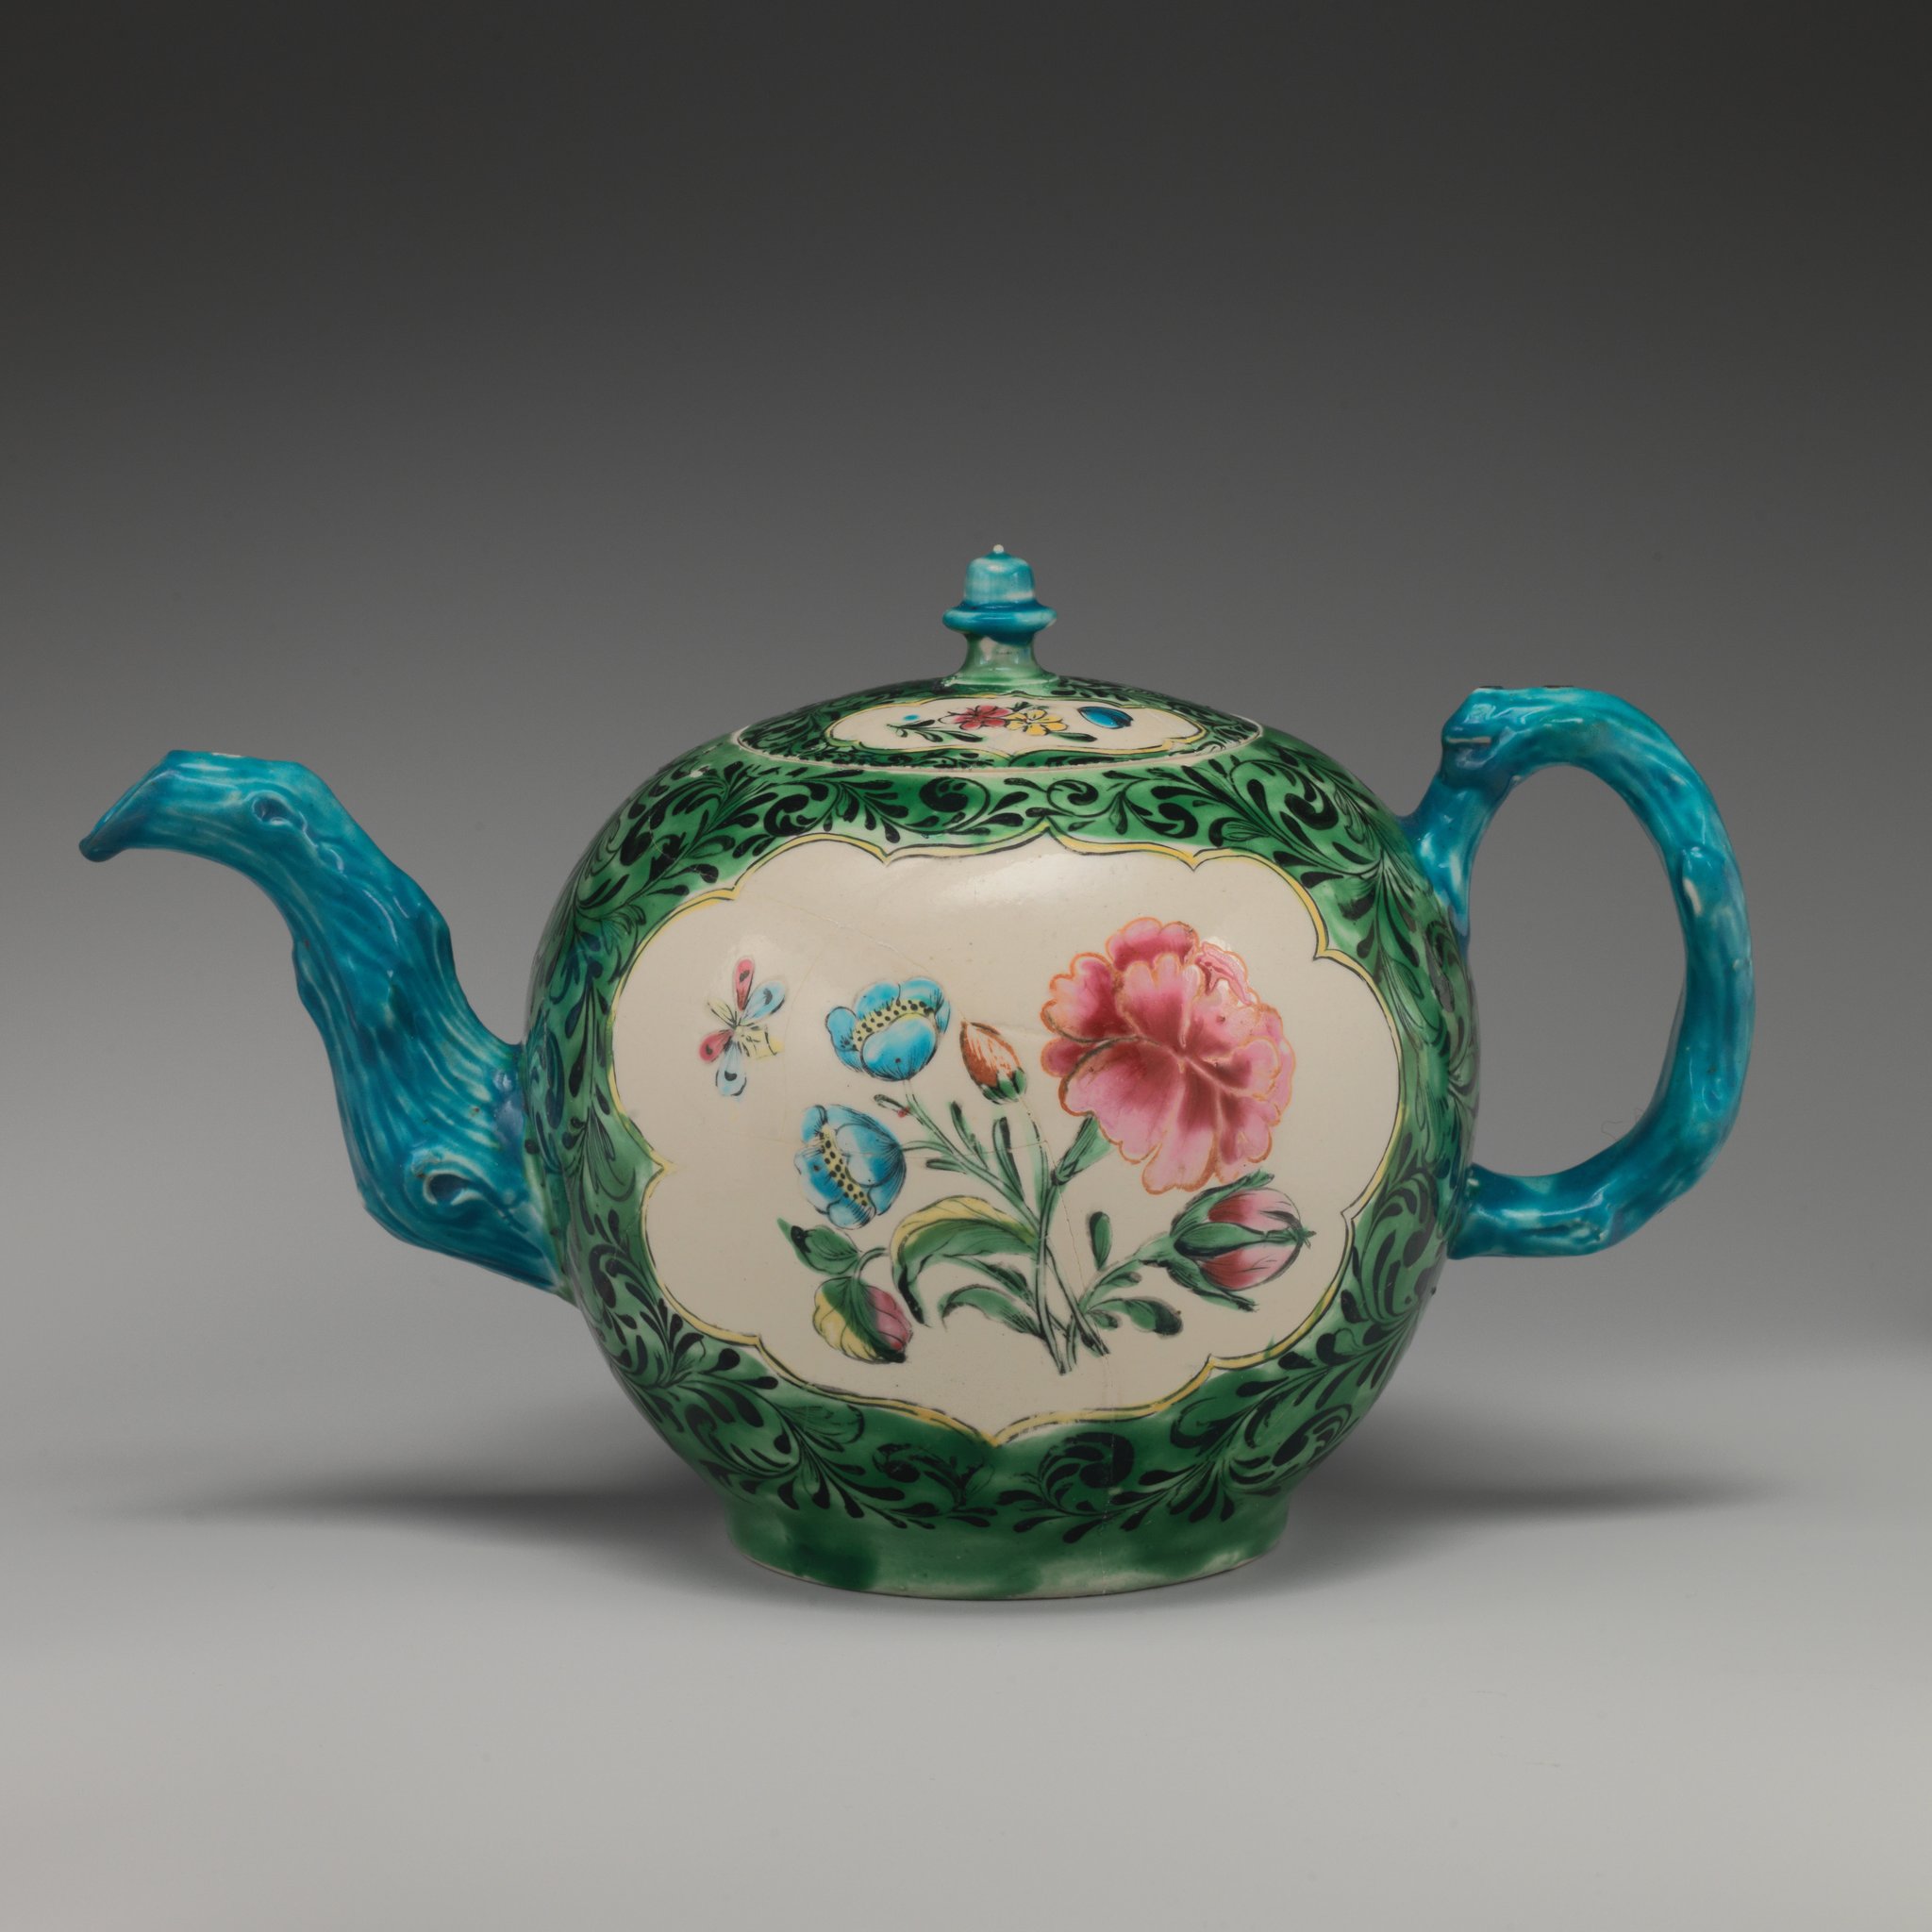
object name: teapot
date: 1765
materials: enamel, stoneware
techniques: salt glaze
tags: flowers